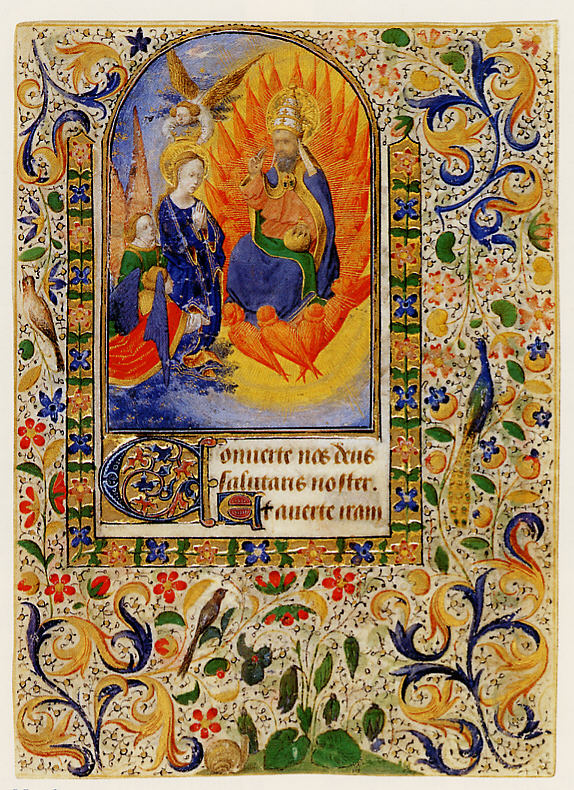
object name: leaf from a book of hour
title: Coronation of the Virgin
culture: french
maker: france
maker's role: artist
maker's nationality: french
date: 1455-1460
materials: gold leaf, parchment, paint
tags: angels,virgin mary